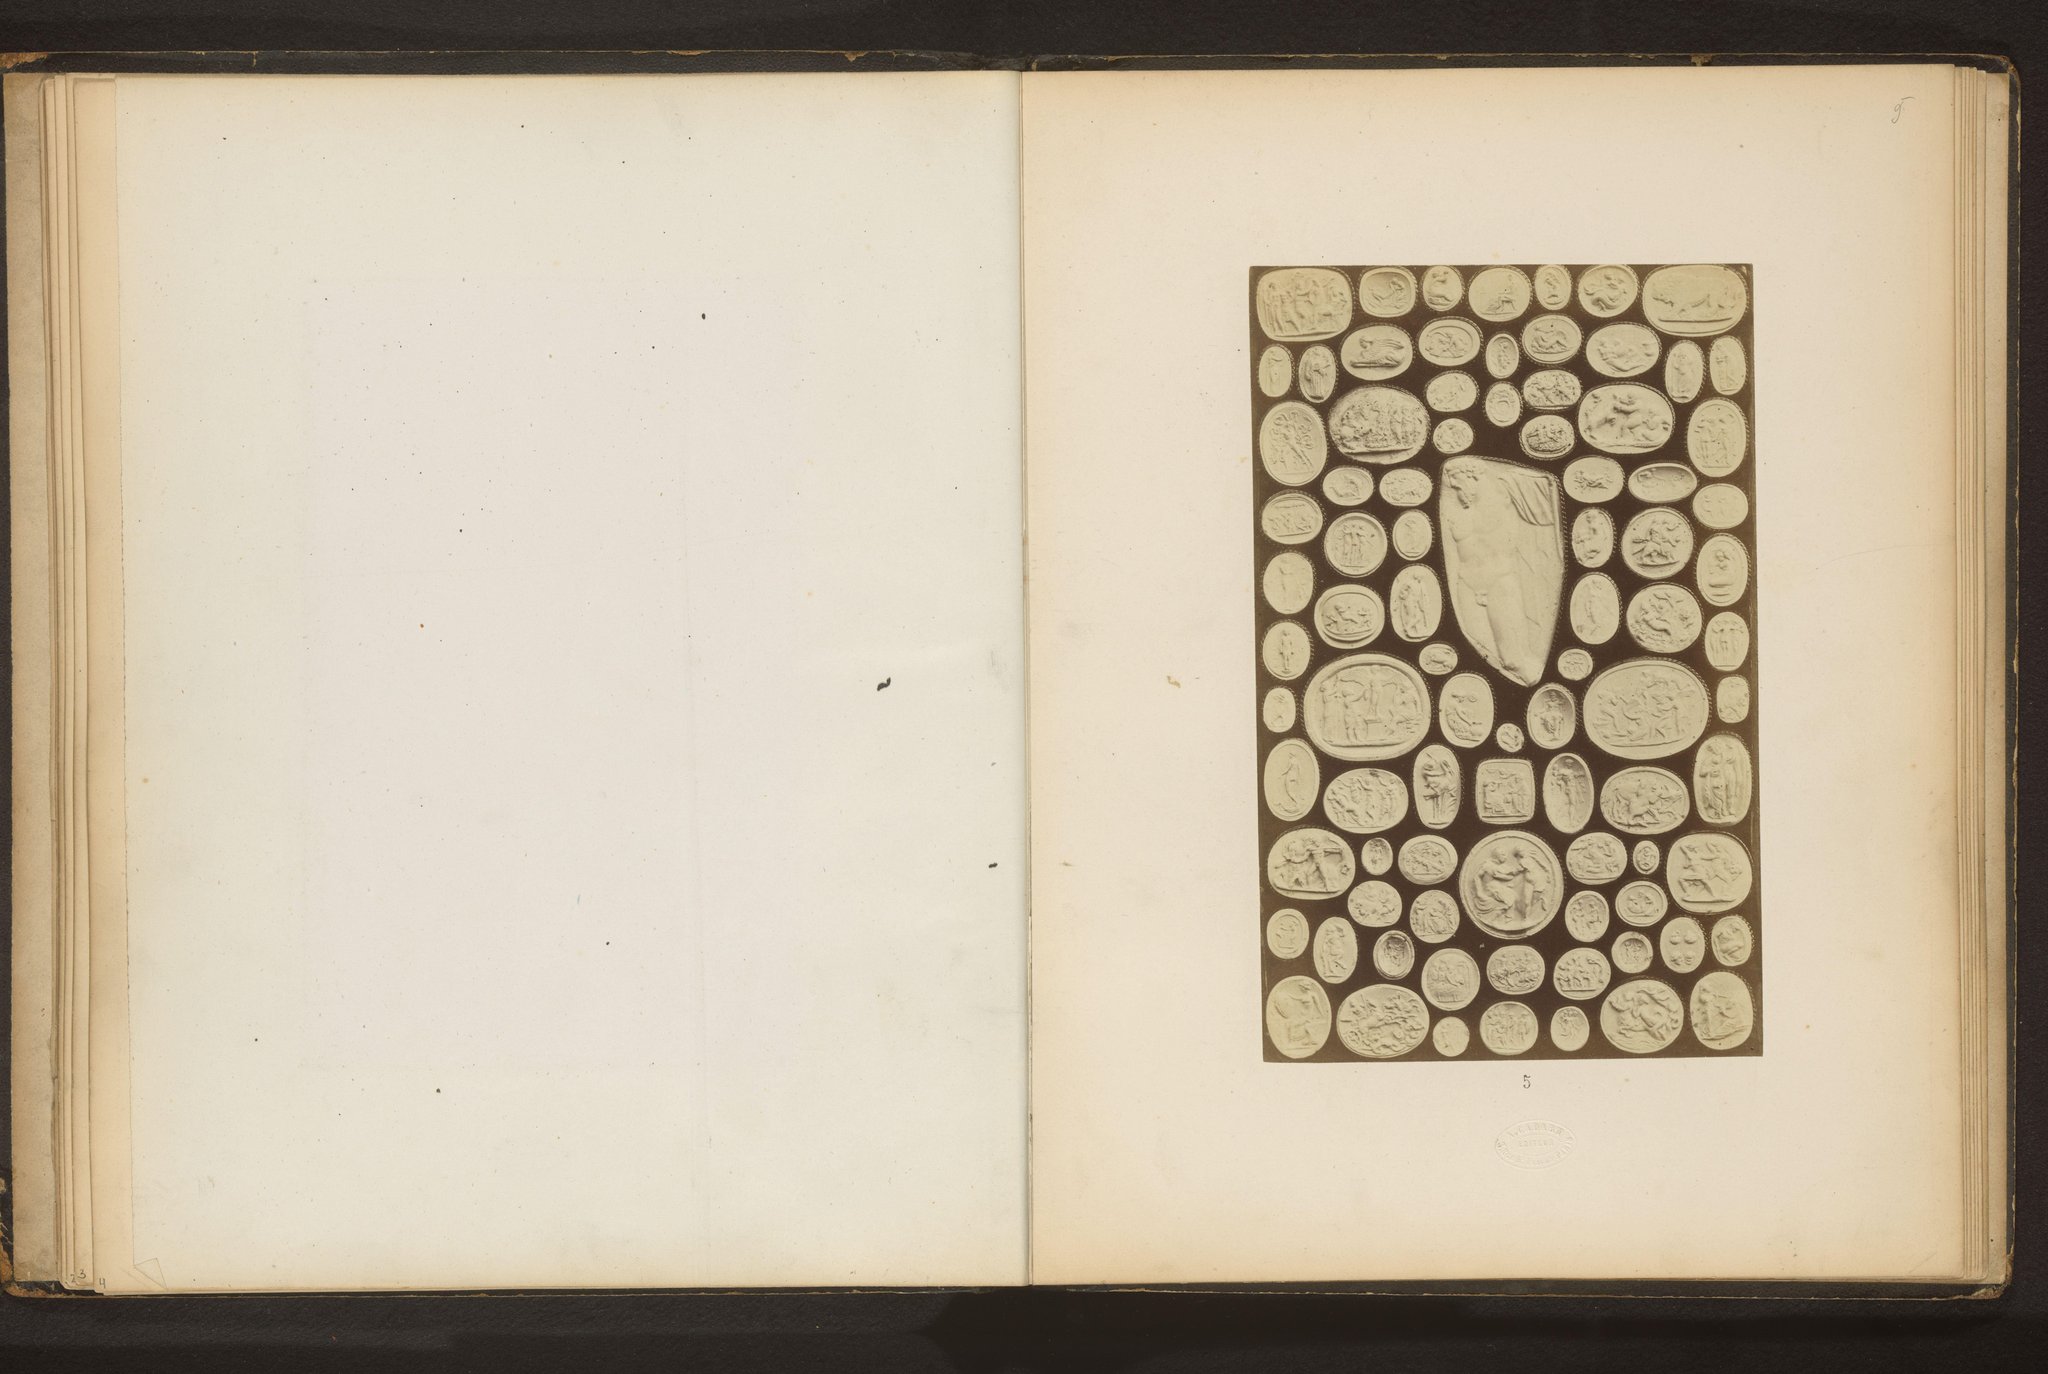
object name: photograph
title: Antieke medailles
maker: Anonymous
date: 1849-1859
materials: photographic support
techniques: albumen print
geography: rome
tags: medal (considered as a piece of sculpture, regardless of its specific function)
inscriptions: number: ‘5’, name: ‘A. Cadart 3. Rue St. Fiacre Paris Editeur’